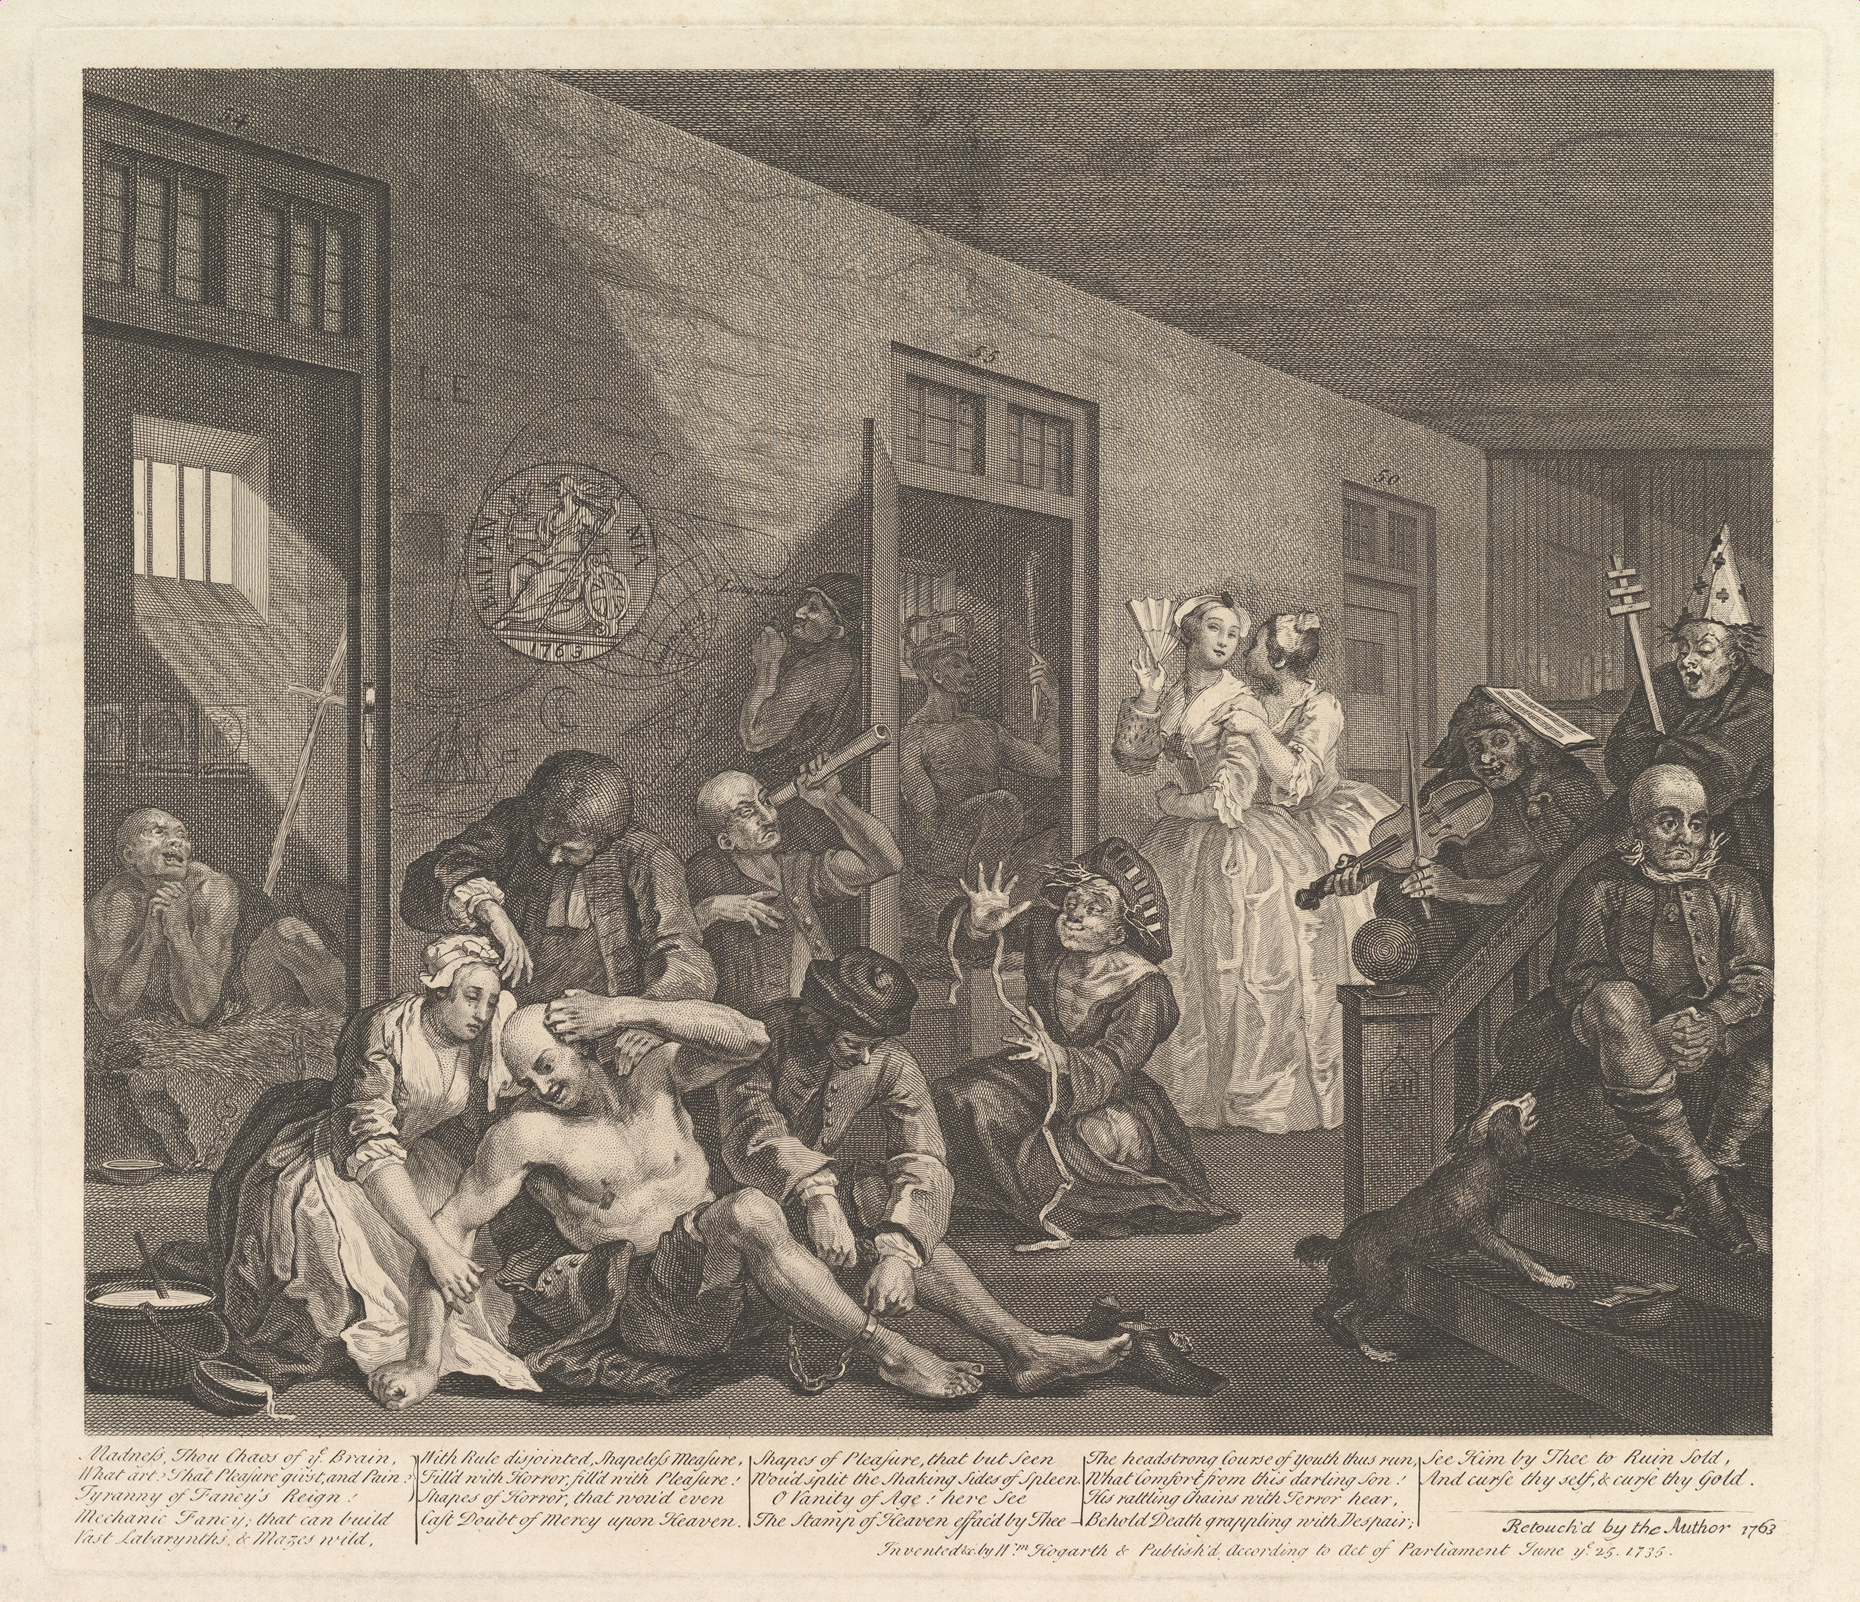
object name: print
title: A Rake's Progress, Plate 8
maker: william hogarth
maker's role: artist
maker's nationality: british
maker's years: 1697-1764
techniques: engraving, etching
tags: interiors,men,women,violins,dogs,cross